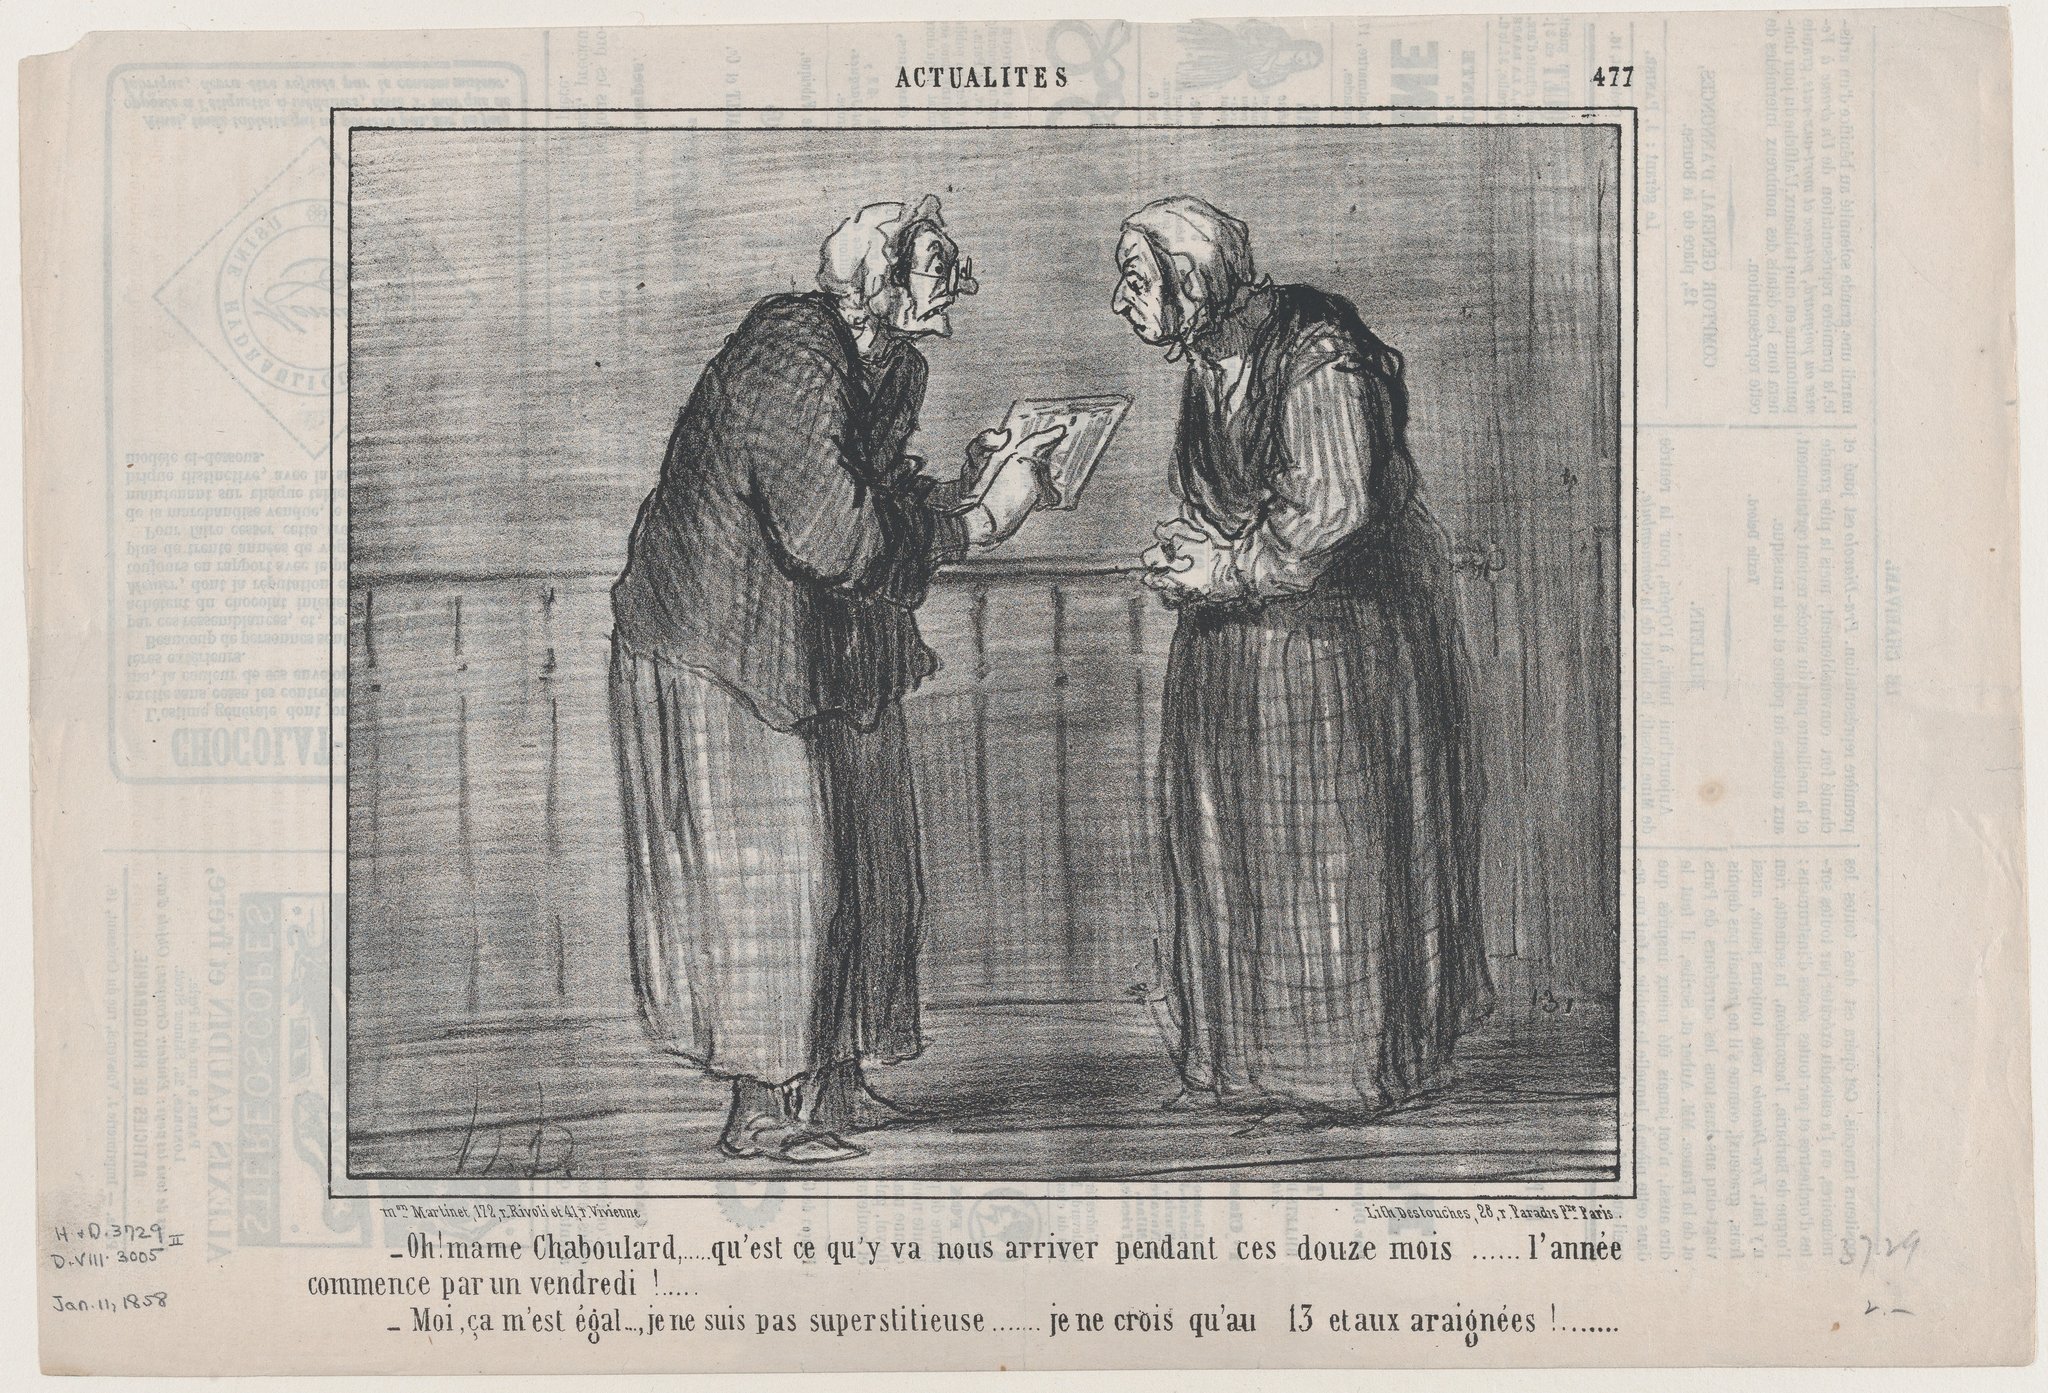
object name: print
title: Oh! mame Chaboulard,... qu'est ce qu'y va nous arriver pendant ces douze mois..., from "Actualités"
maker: honoré daumier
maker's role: artist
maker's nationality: french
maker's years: 1808-1879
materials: paper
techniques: lithograph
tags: women